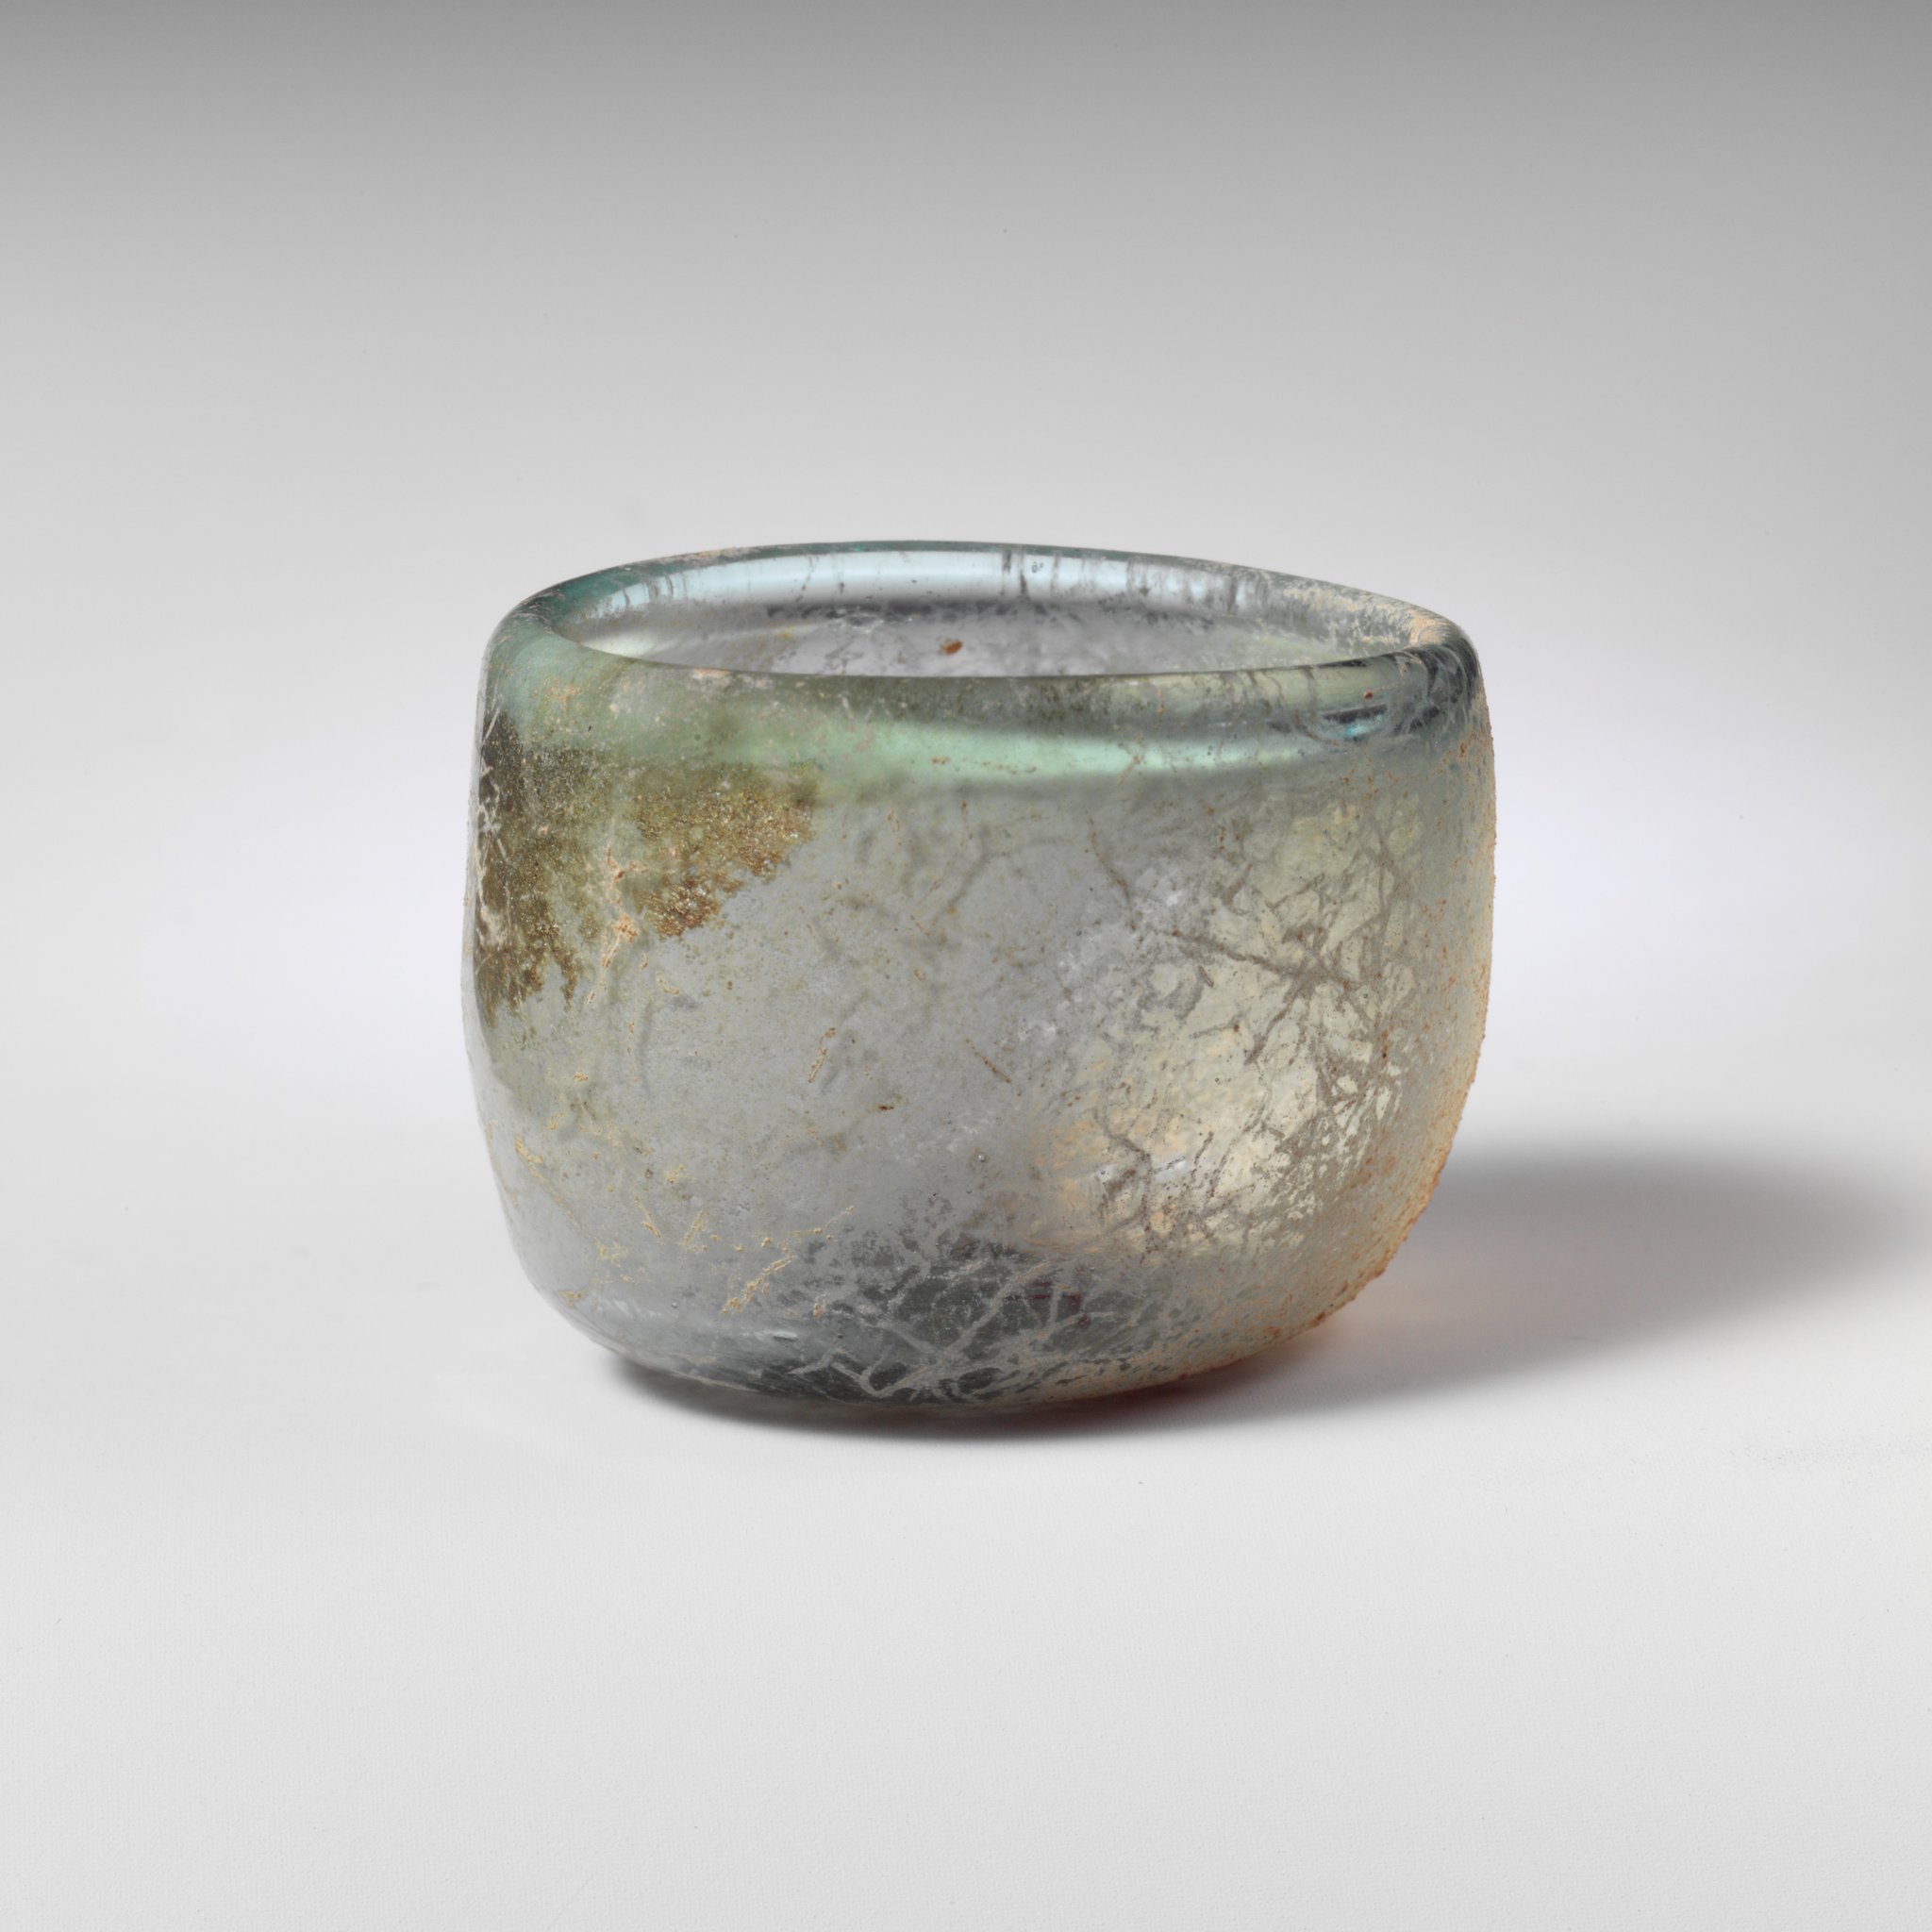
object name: bowl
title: Glass bowl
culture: roman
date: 101-300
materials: glass